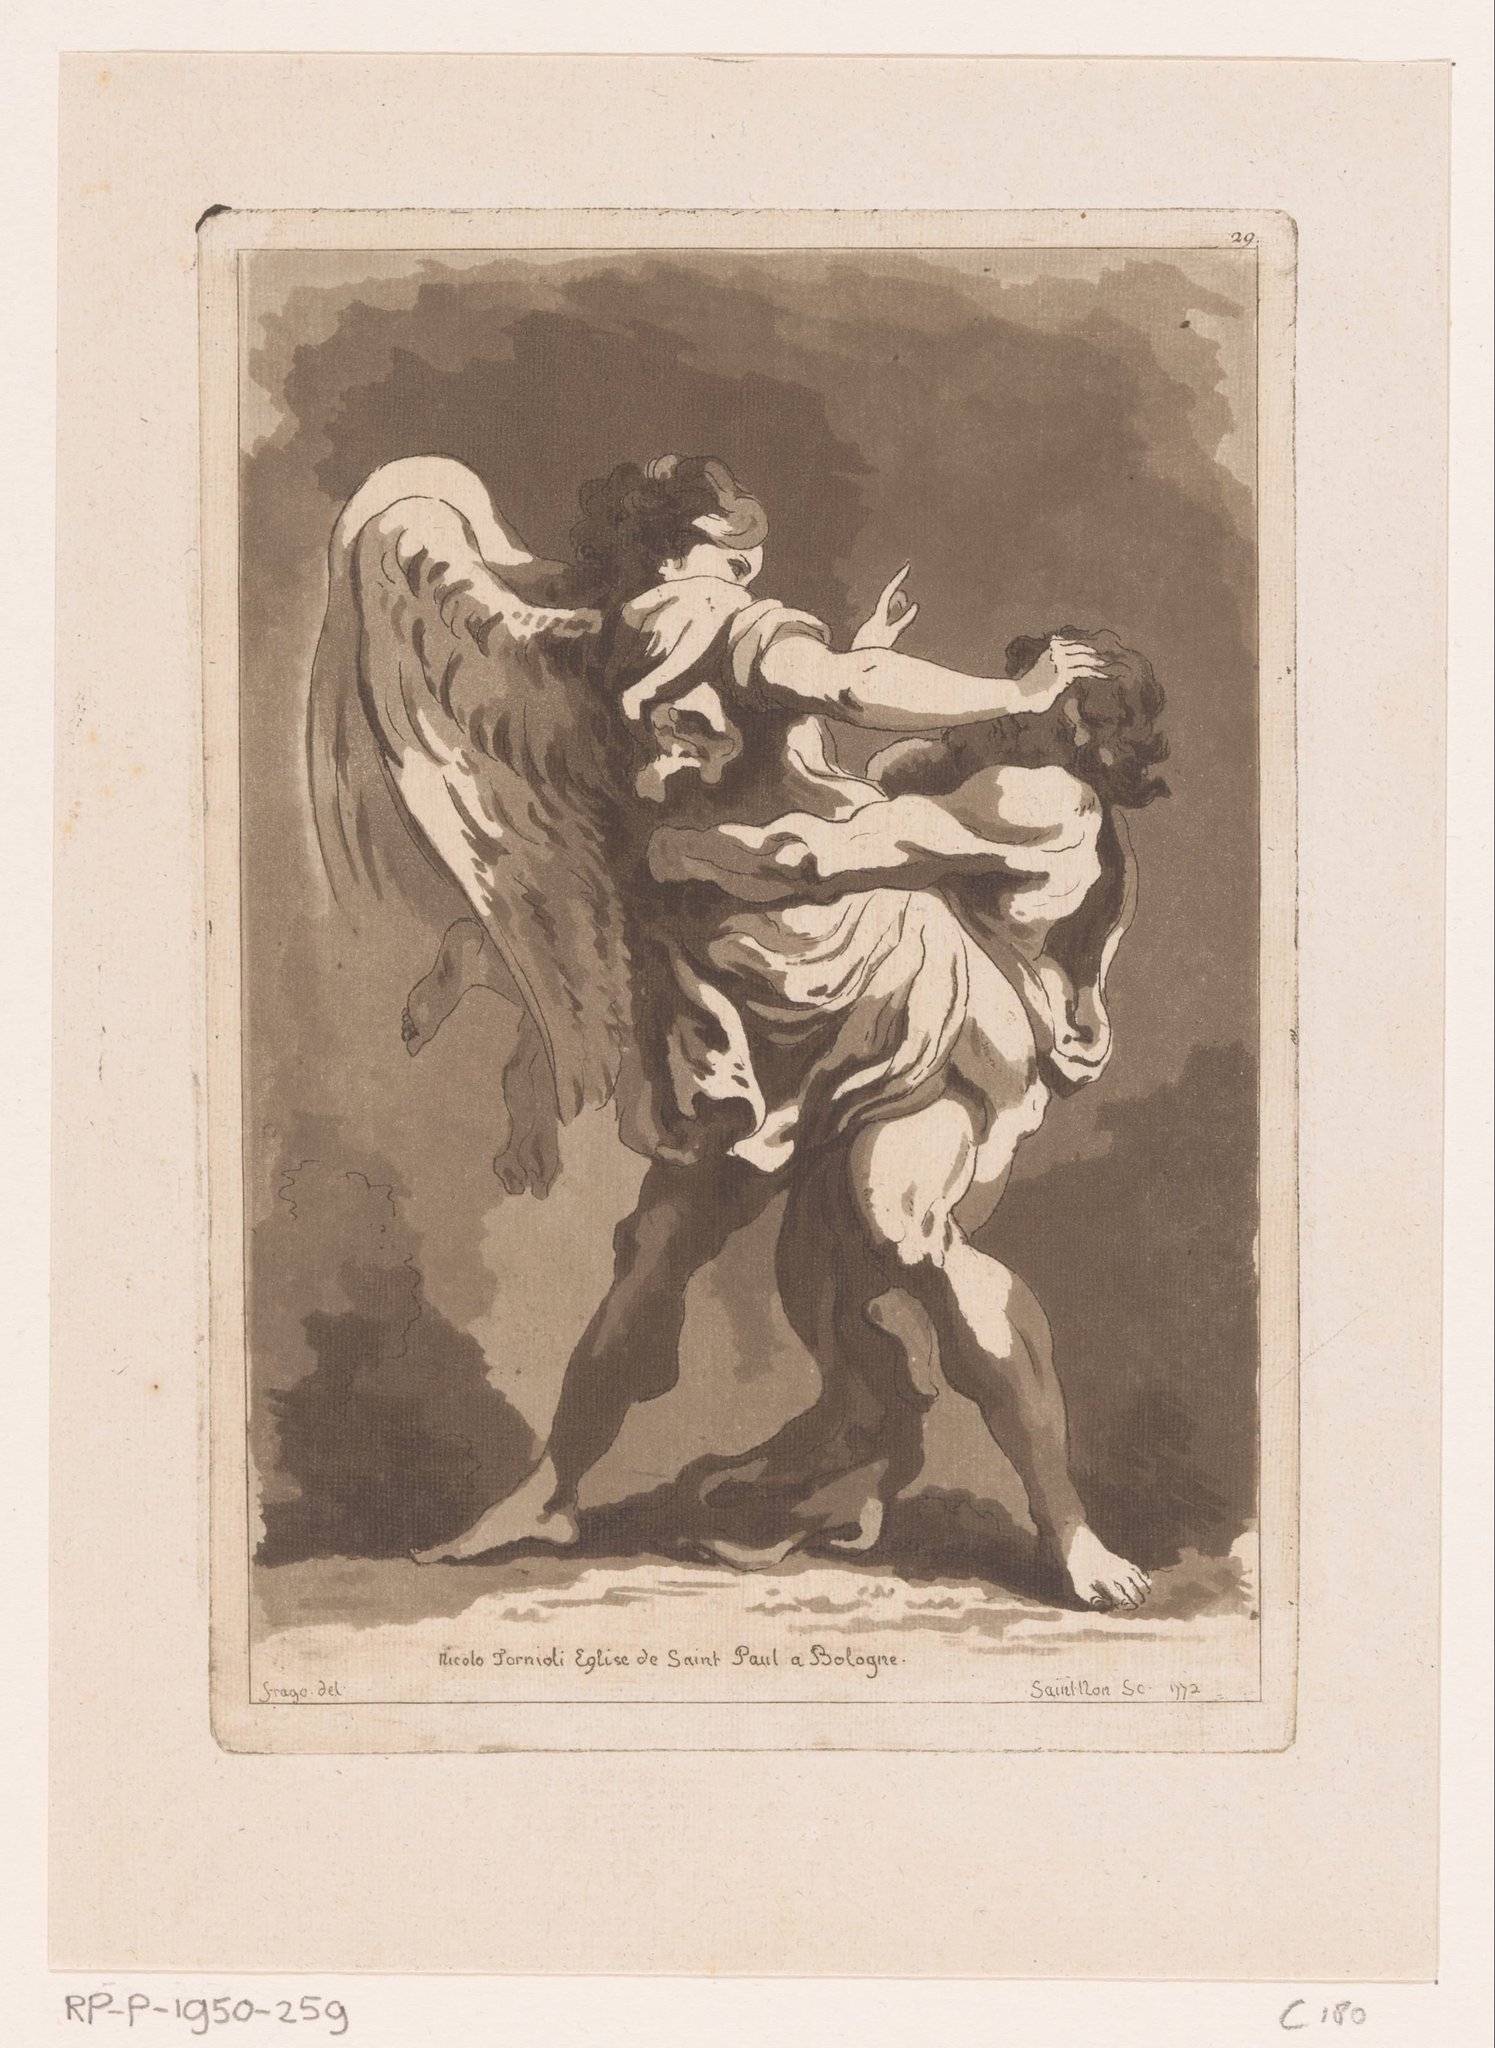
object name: print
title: Fragments choisis dans les peintures et les tableaux les plus intéressants de l'Italie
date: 1772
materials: paper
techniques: aquatint, etching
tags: jacob wrestles with the angel (or man) till daybreak; jacob's thigh is put out of joint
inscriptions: collector's mark: Lugt 2228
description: Prent maakt deel uit van een serie met daarbinnen delen over specifiek Rome, Bologna, Napels en Venetië.